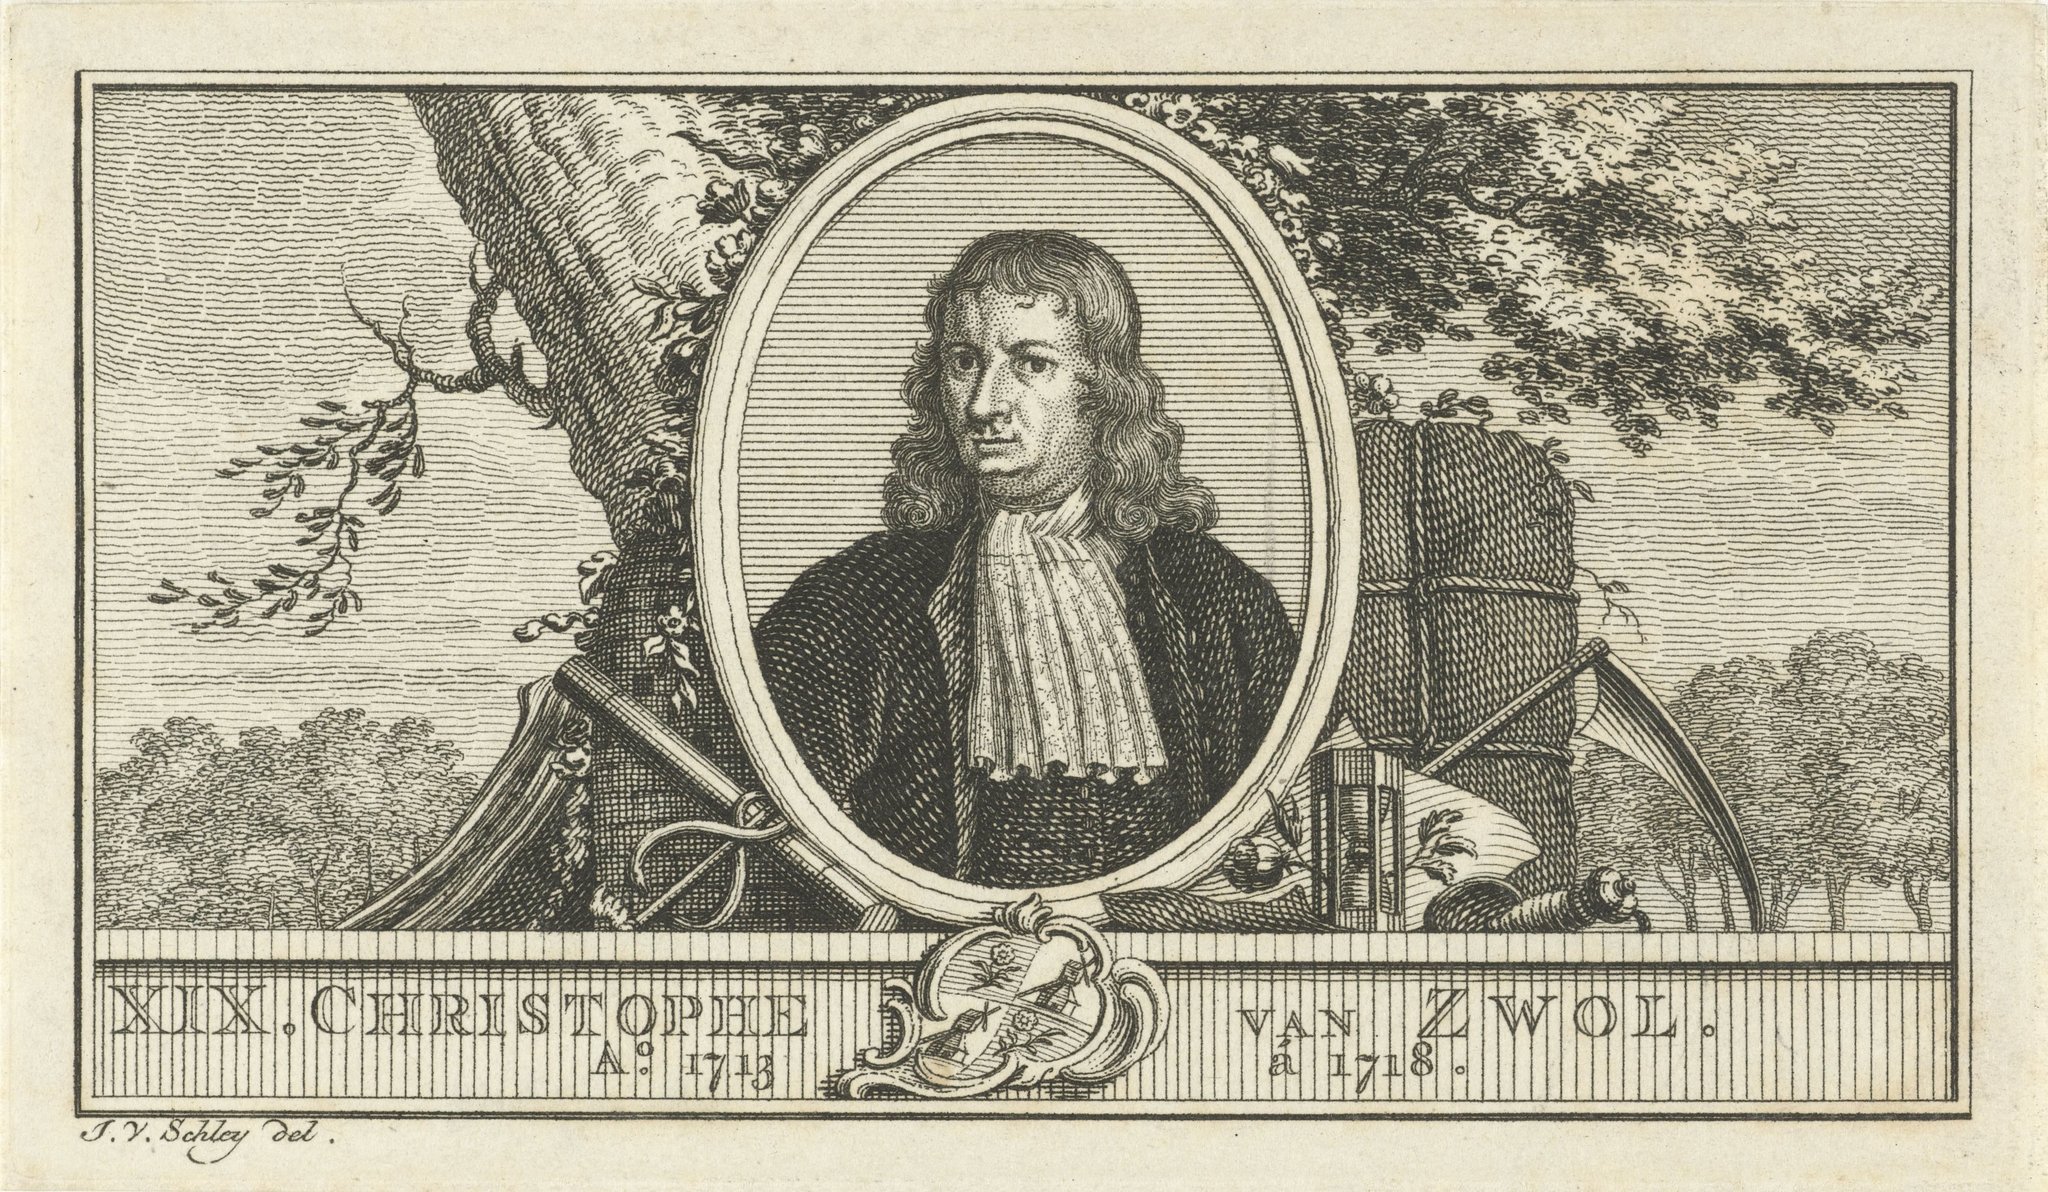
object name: print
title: Portret van Christoffel van Swol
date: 1763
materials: paper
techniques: engraving, etching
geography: the hague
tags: trees, hourglass, caduceus (staff with two snakes, attribute of mercury)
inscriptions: collector's mark: Lugt 964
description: Ook gebruikt als illustratie in: Du Bois, J.P.I. Vies des gouverneurs généraux avec l'abrégé de l'histoire des établissemens hollandais aux Indes Orientales. Den Haag: Pierre de Hondt, 1763, p. 288.